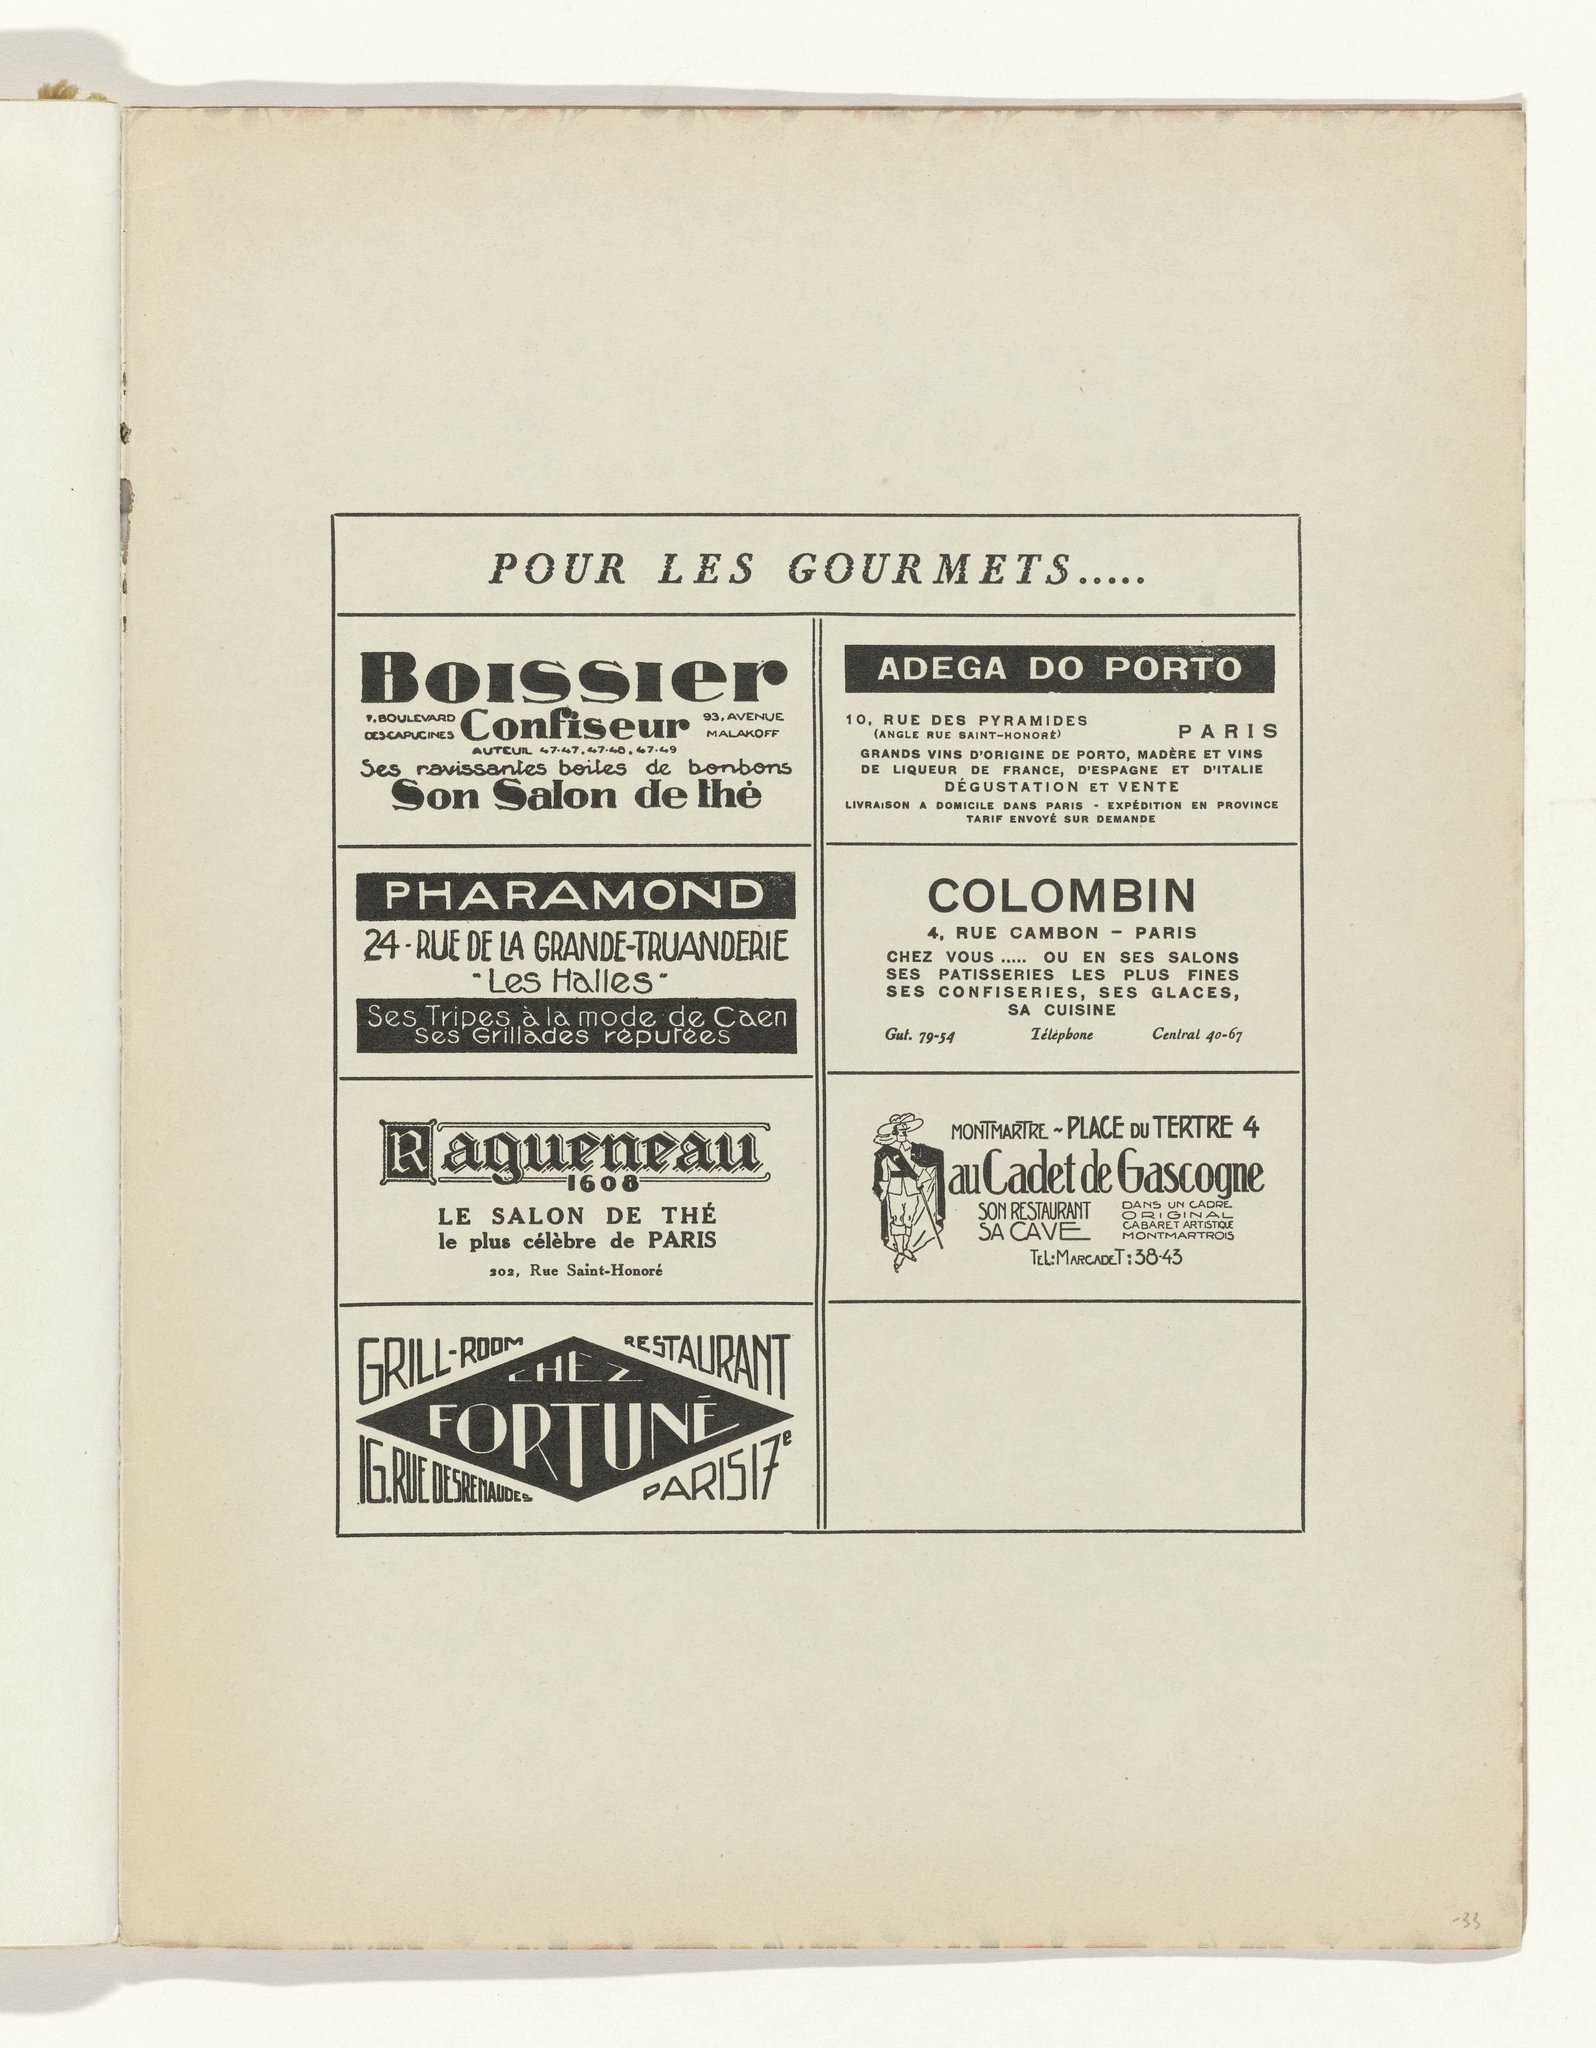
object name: magazine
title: Art - Goût - Beauté, Feuillets de l' élégance féminine, Mai 1929, No. 105, 9e Année, p. 33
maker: charles goy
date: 1929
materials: paper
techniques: letterpress printing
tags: fashion plates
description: Pagina met advertenties uit het modetijdschrift Art-Goût-Beauté (1920-1933).